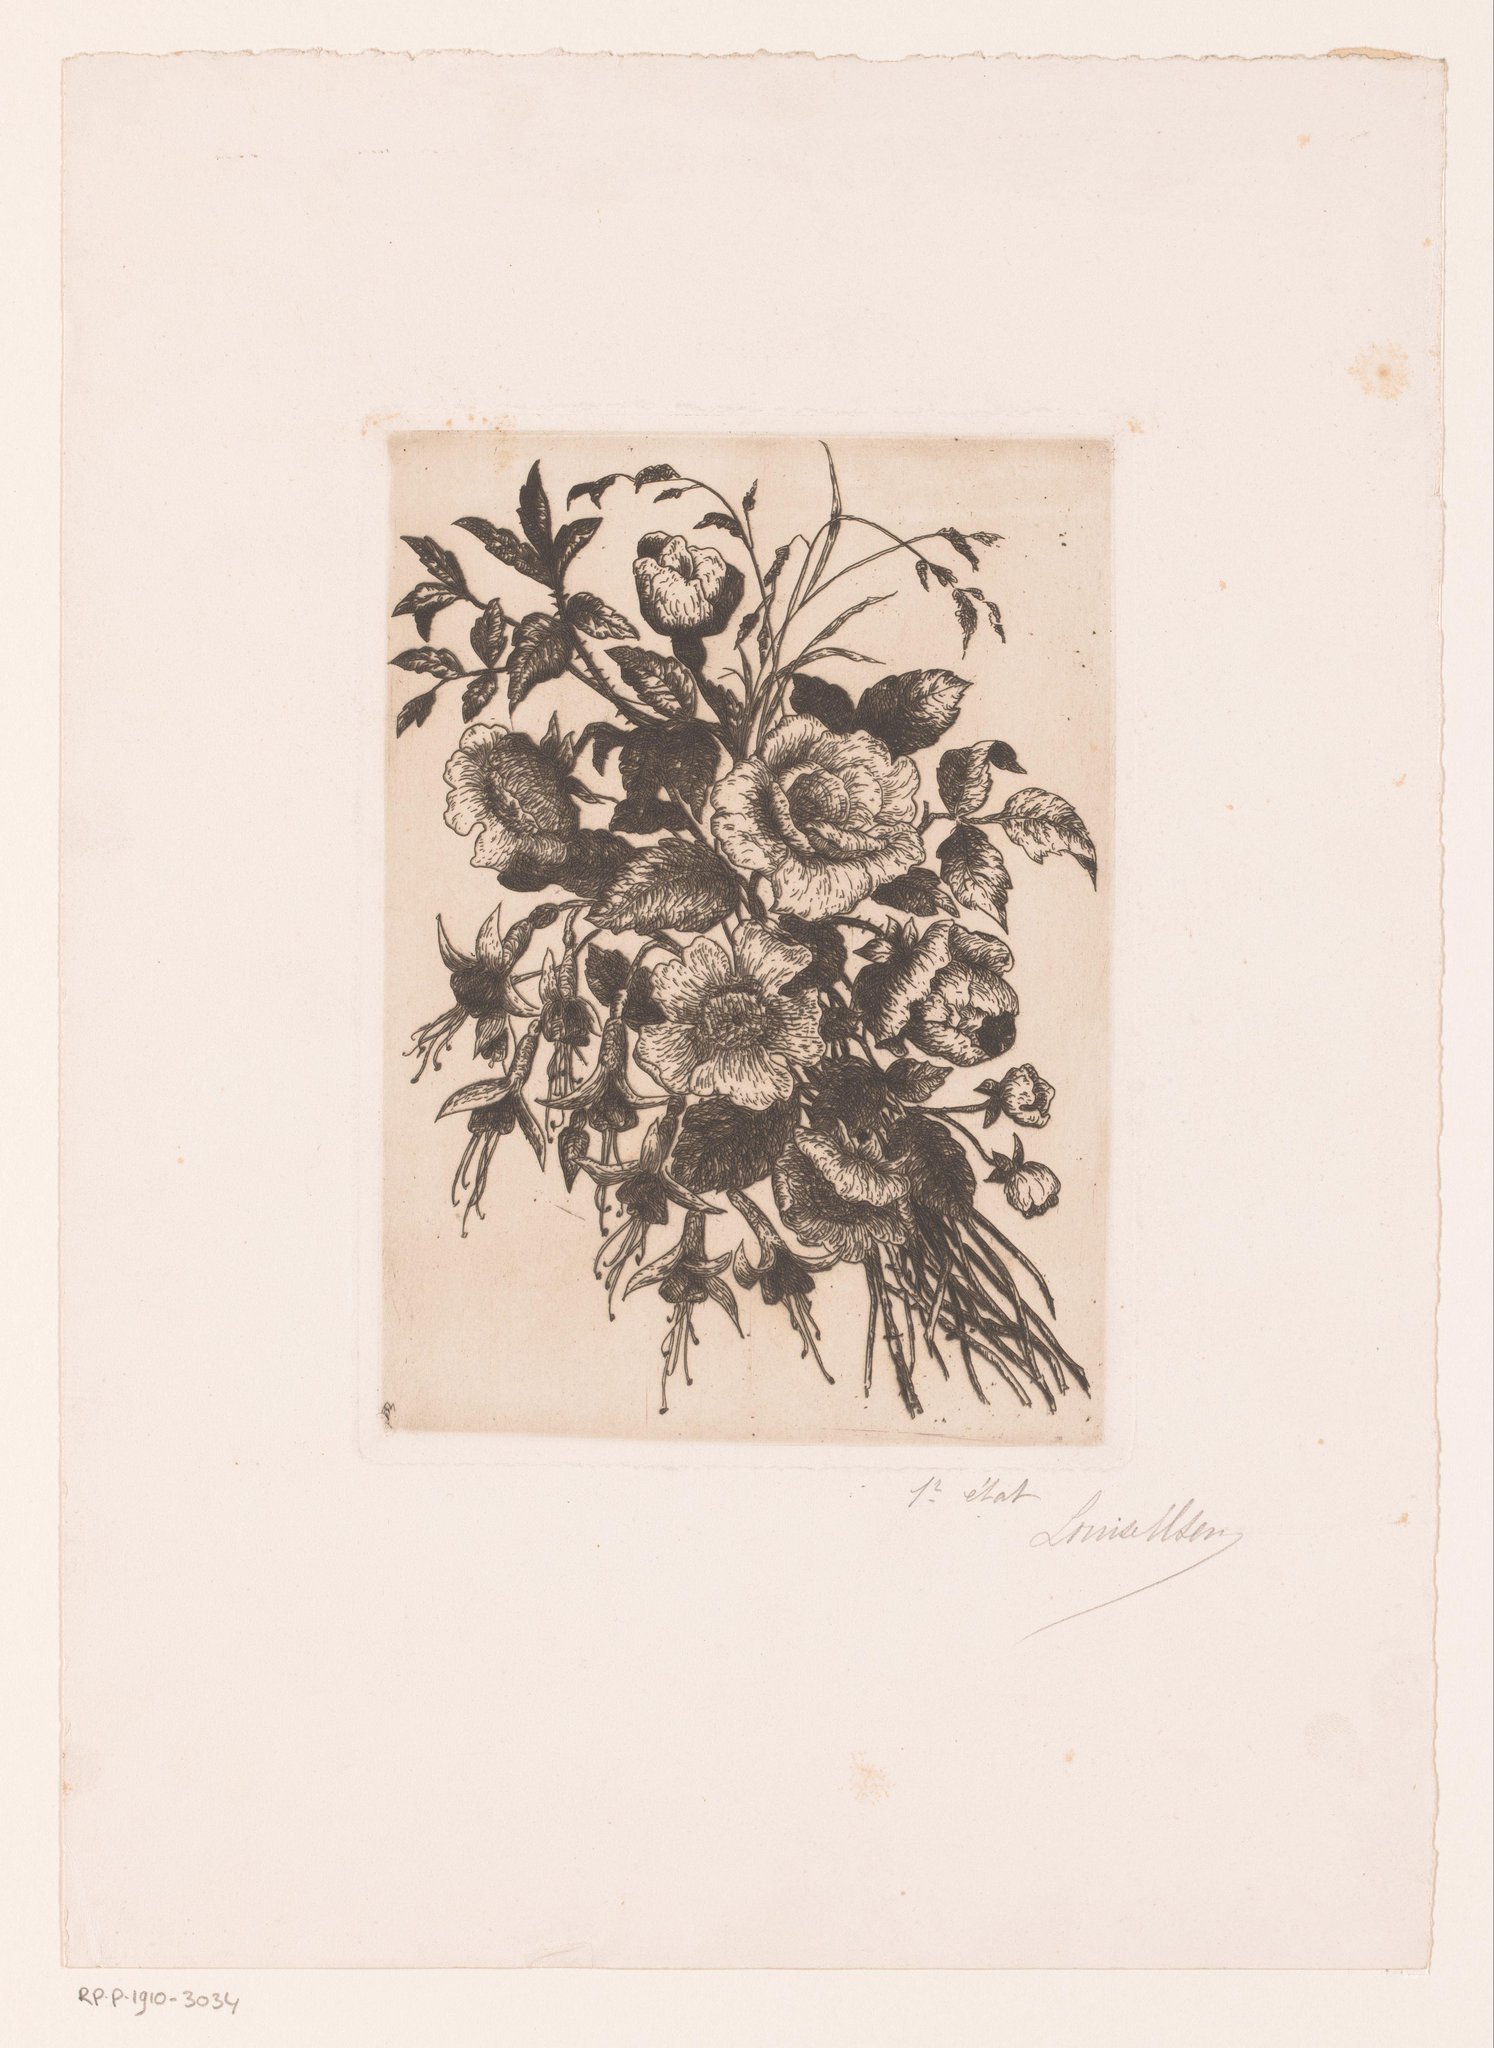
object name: print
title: Bloemstilleven met rozen en anemonen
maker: louise elsen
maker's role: print maker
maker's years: 1853-1937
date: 1860-1888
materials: paper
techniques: etching, intaglio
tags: flowers: anemone, still life of plants, flowers and fruit, flowers: rose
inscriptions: inscription: ‘1e état’, collector's mark: Lugt 2228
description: Onder andere rozen en anemonen in het midden, een pioenroos rechts en fuchsia linksonder.